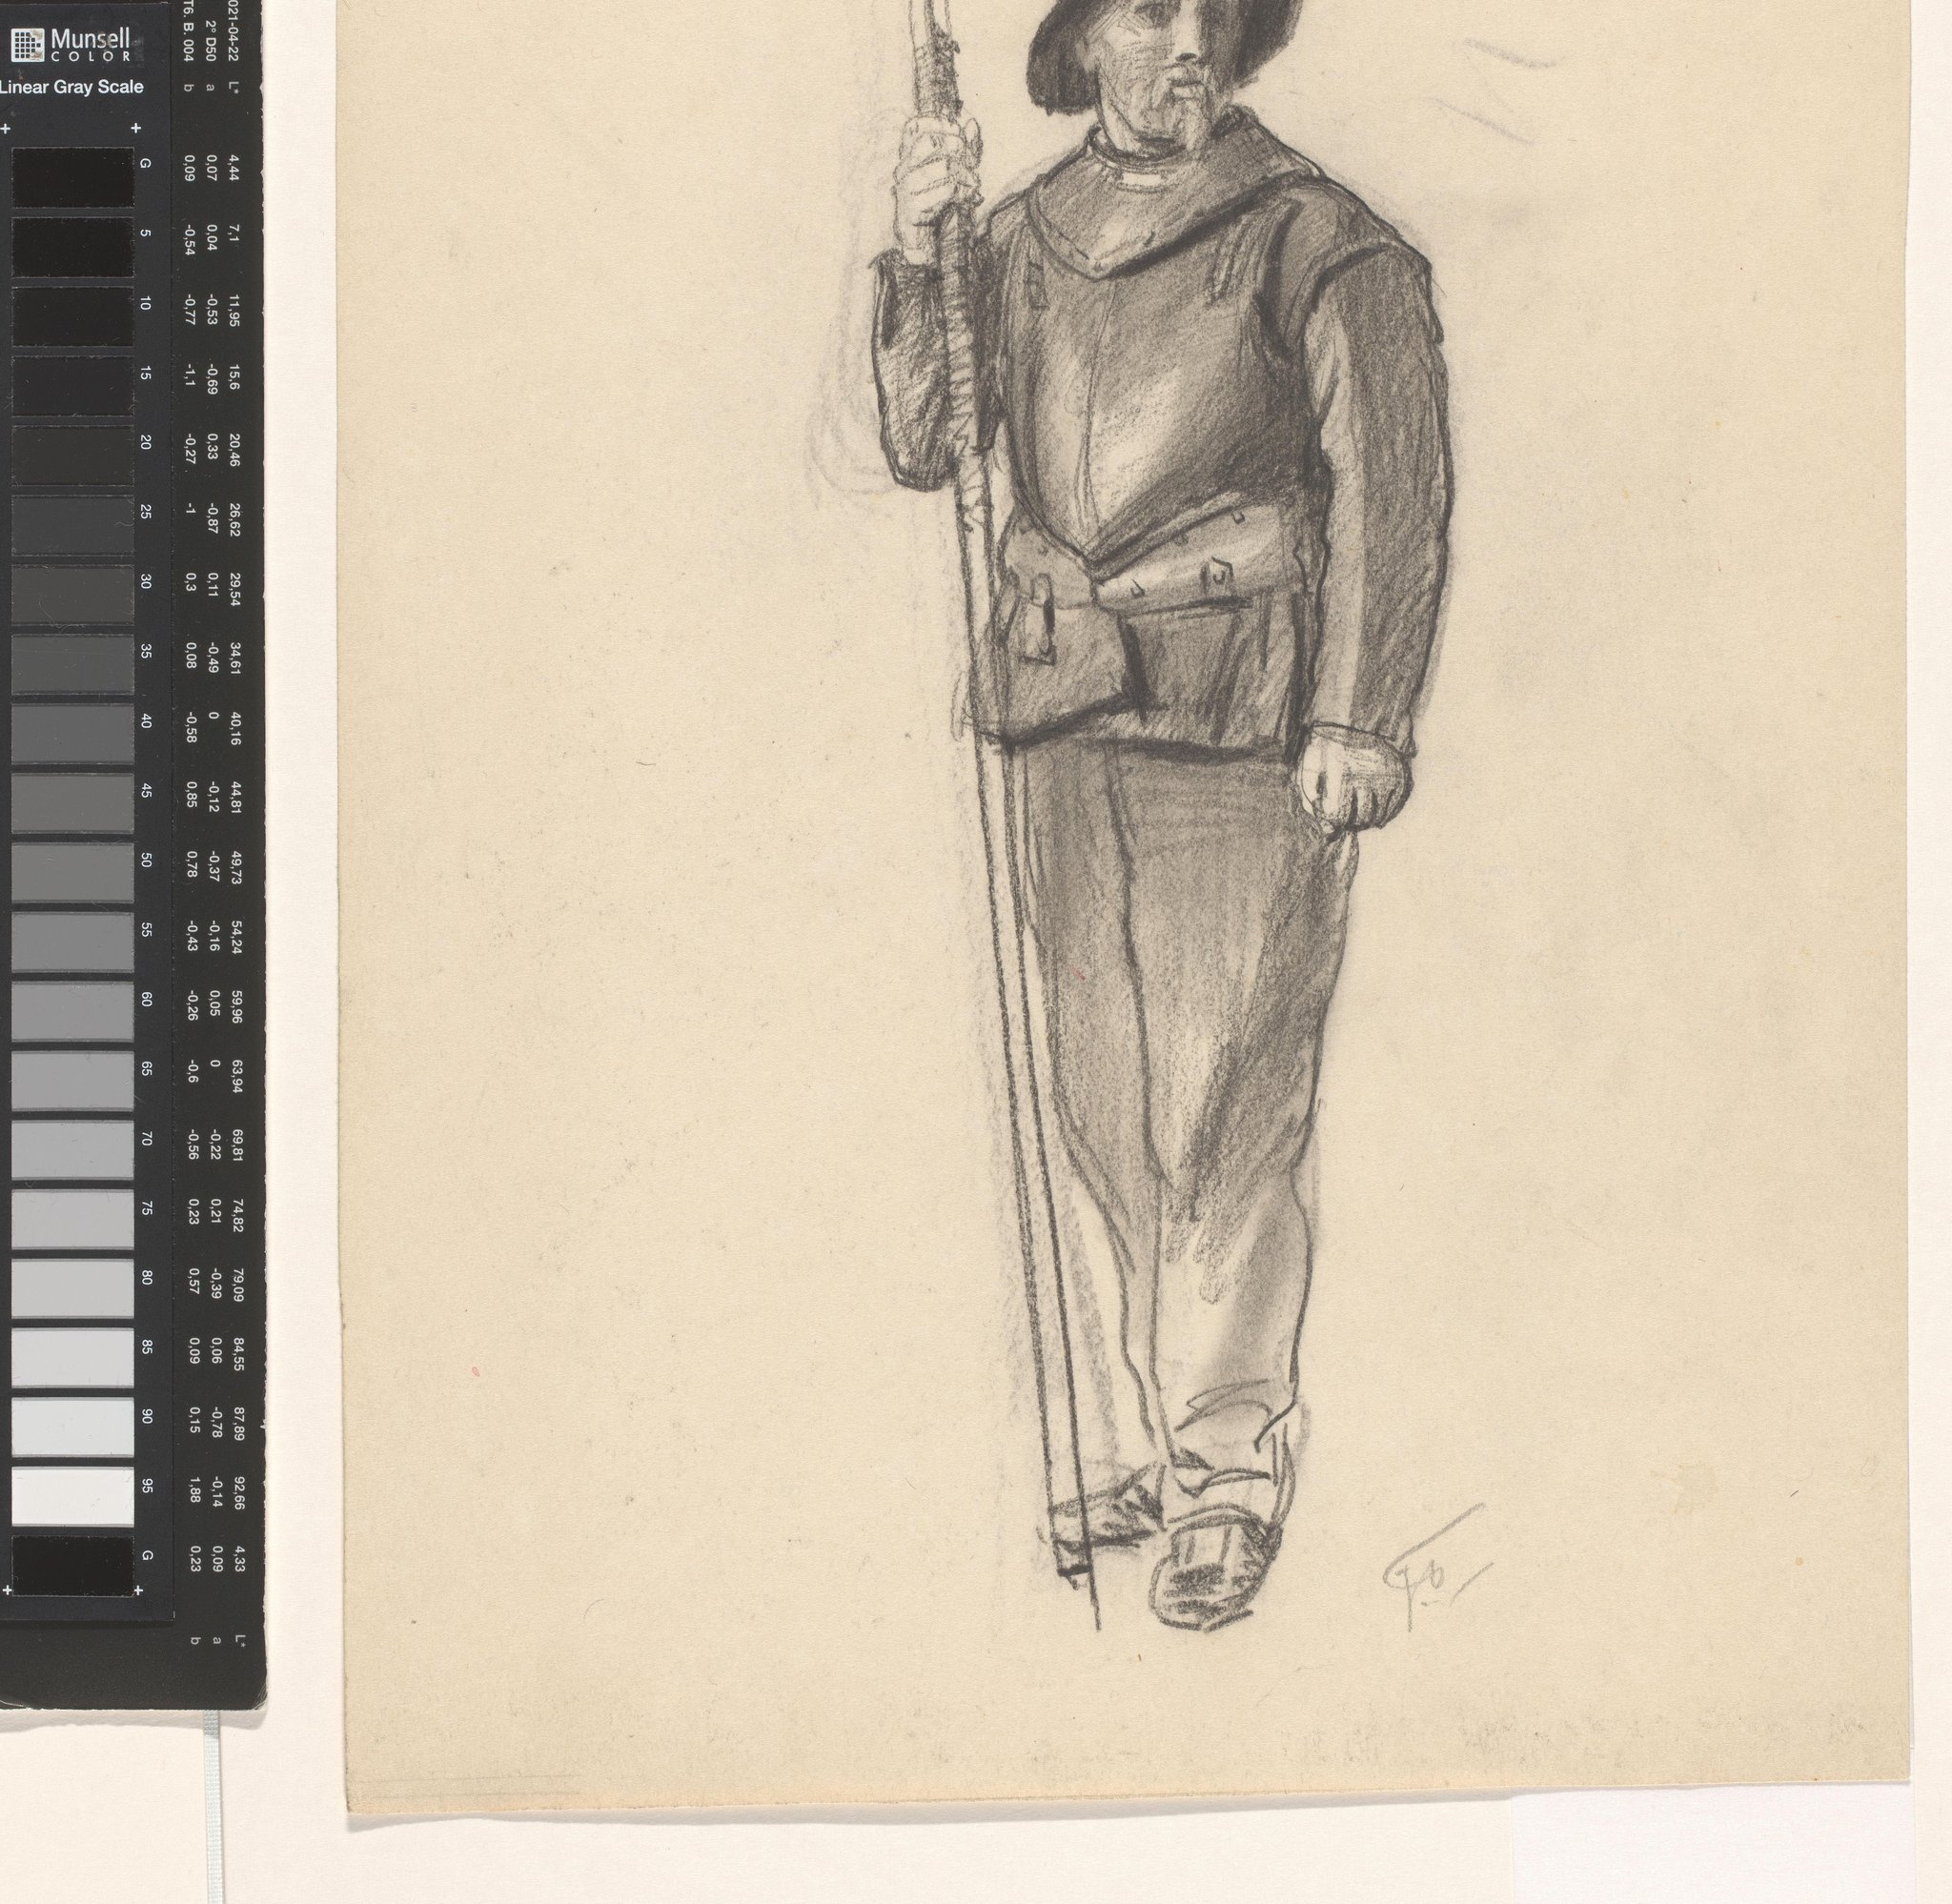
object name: drawing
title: Figuurstudie van mannelijk model in antiek harnas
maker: jacob taanman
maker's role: draughtsman, print maker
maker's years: 1836-1923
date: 1886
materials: chalk, paper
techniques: drawing, stumping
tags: private soldier, harness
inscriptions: monogram: ‘J.T’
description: Studie in voorbereiding op de compositie 'De oude schepenenkamer te Naarden'.